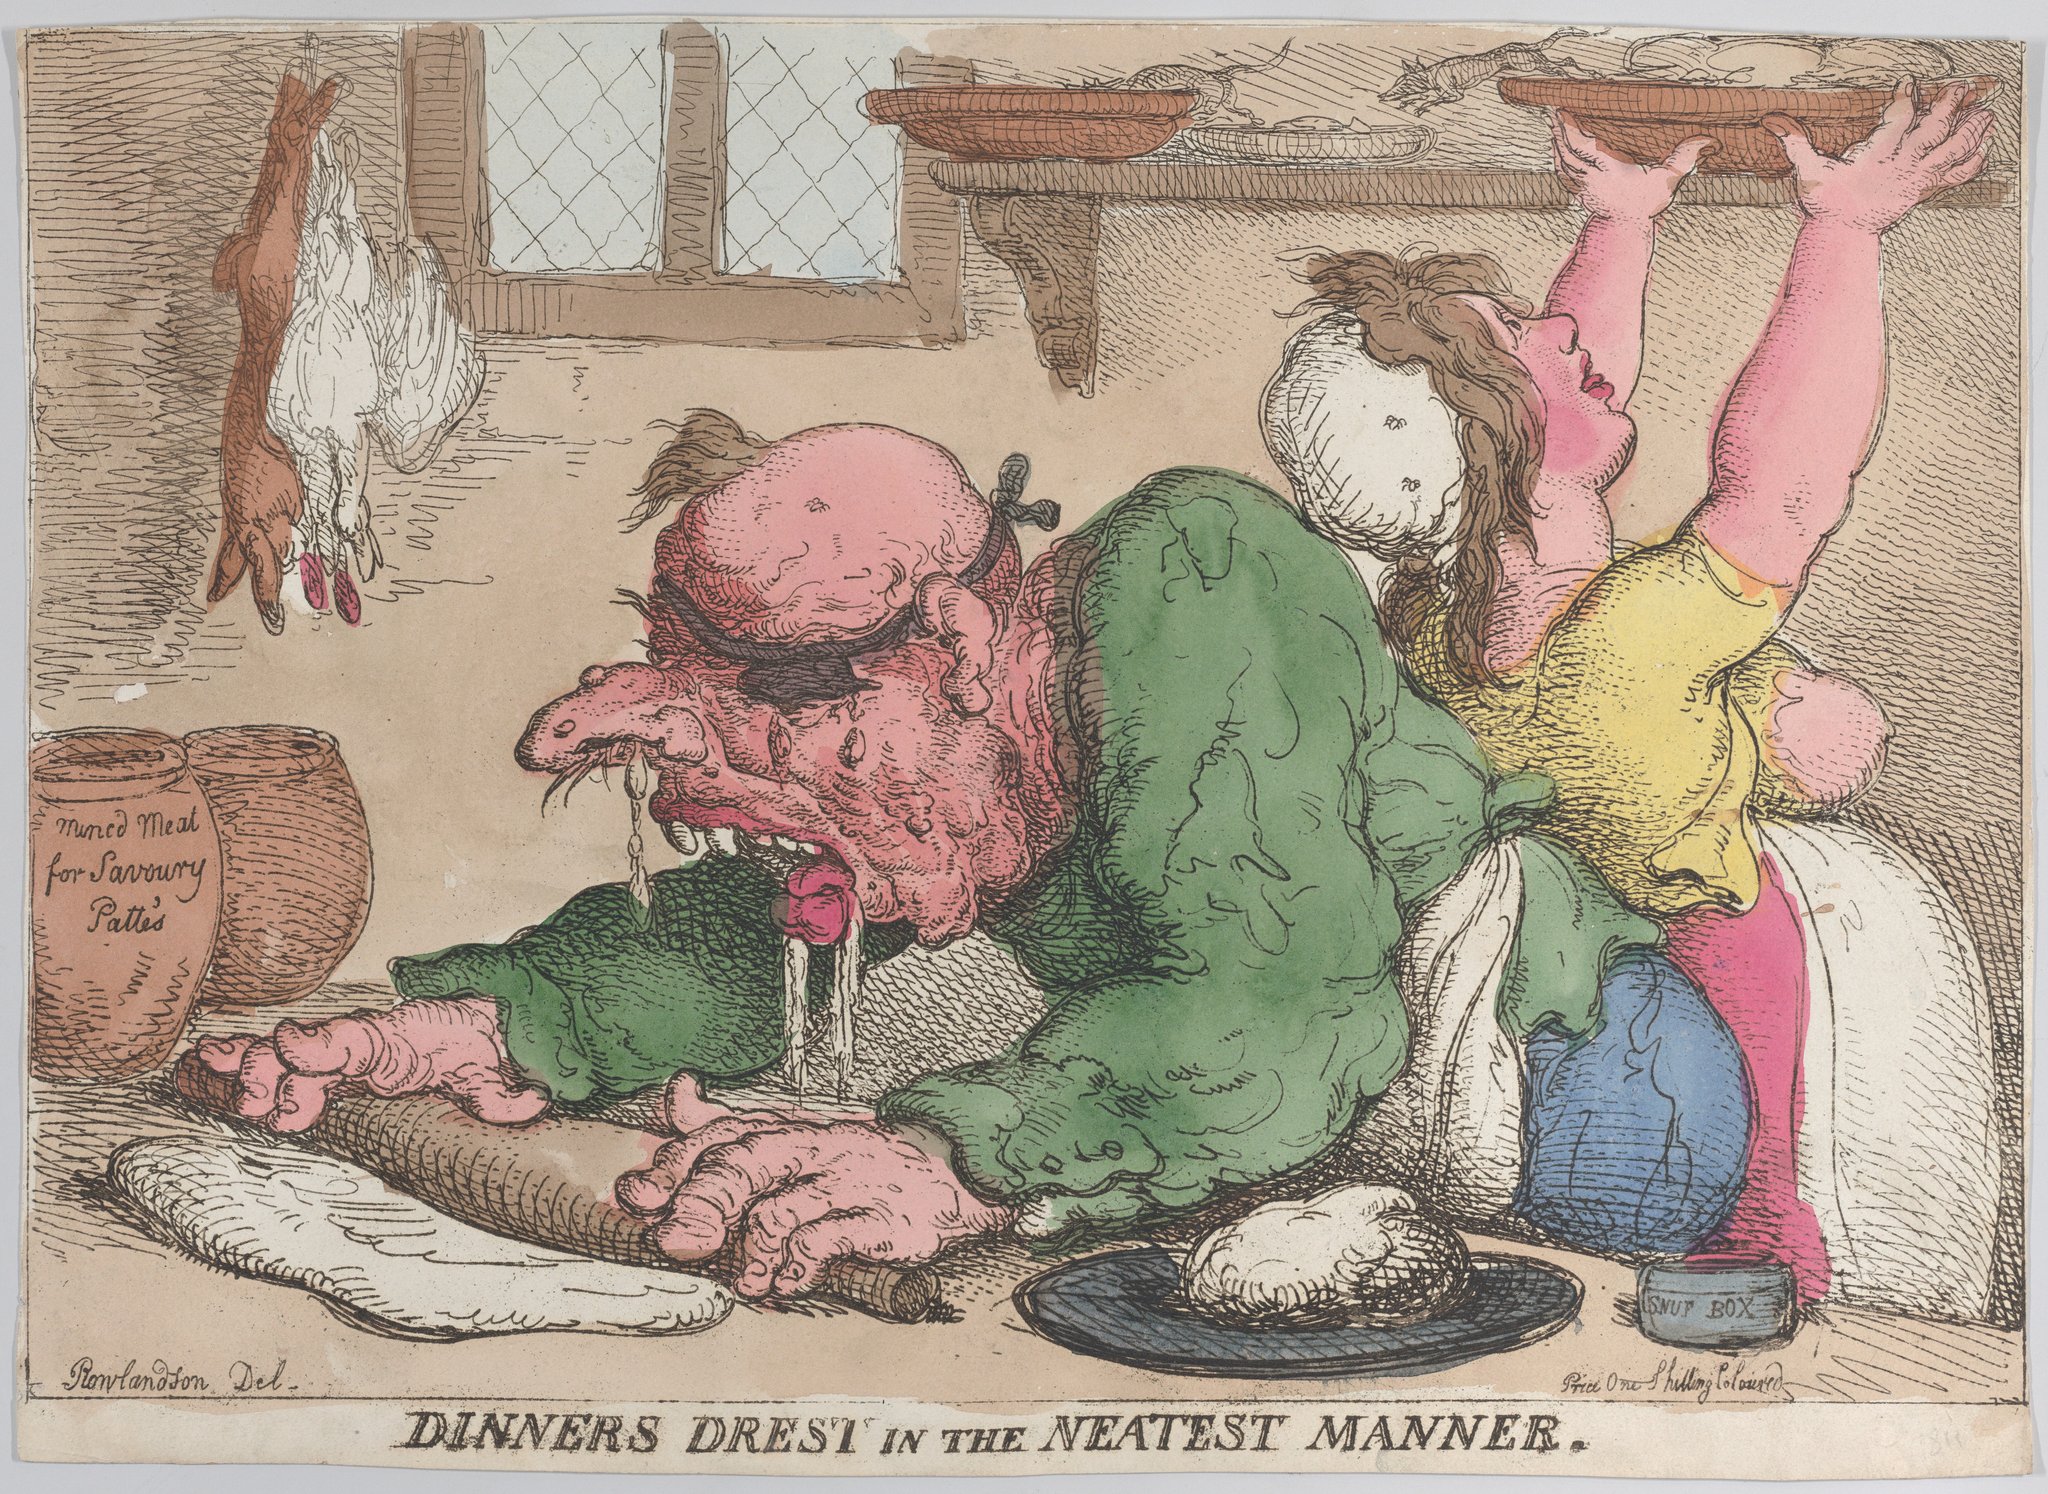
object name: print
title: Dinners Drest in the Neatest Manner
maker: thomas rowlandson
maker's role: artist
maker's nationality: british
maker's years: 1757-1827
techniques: etching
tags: satire,kitchens,men,women,cooking